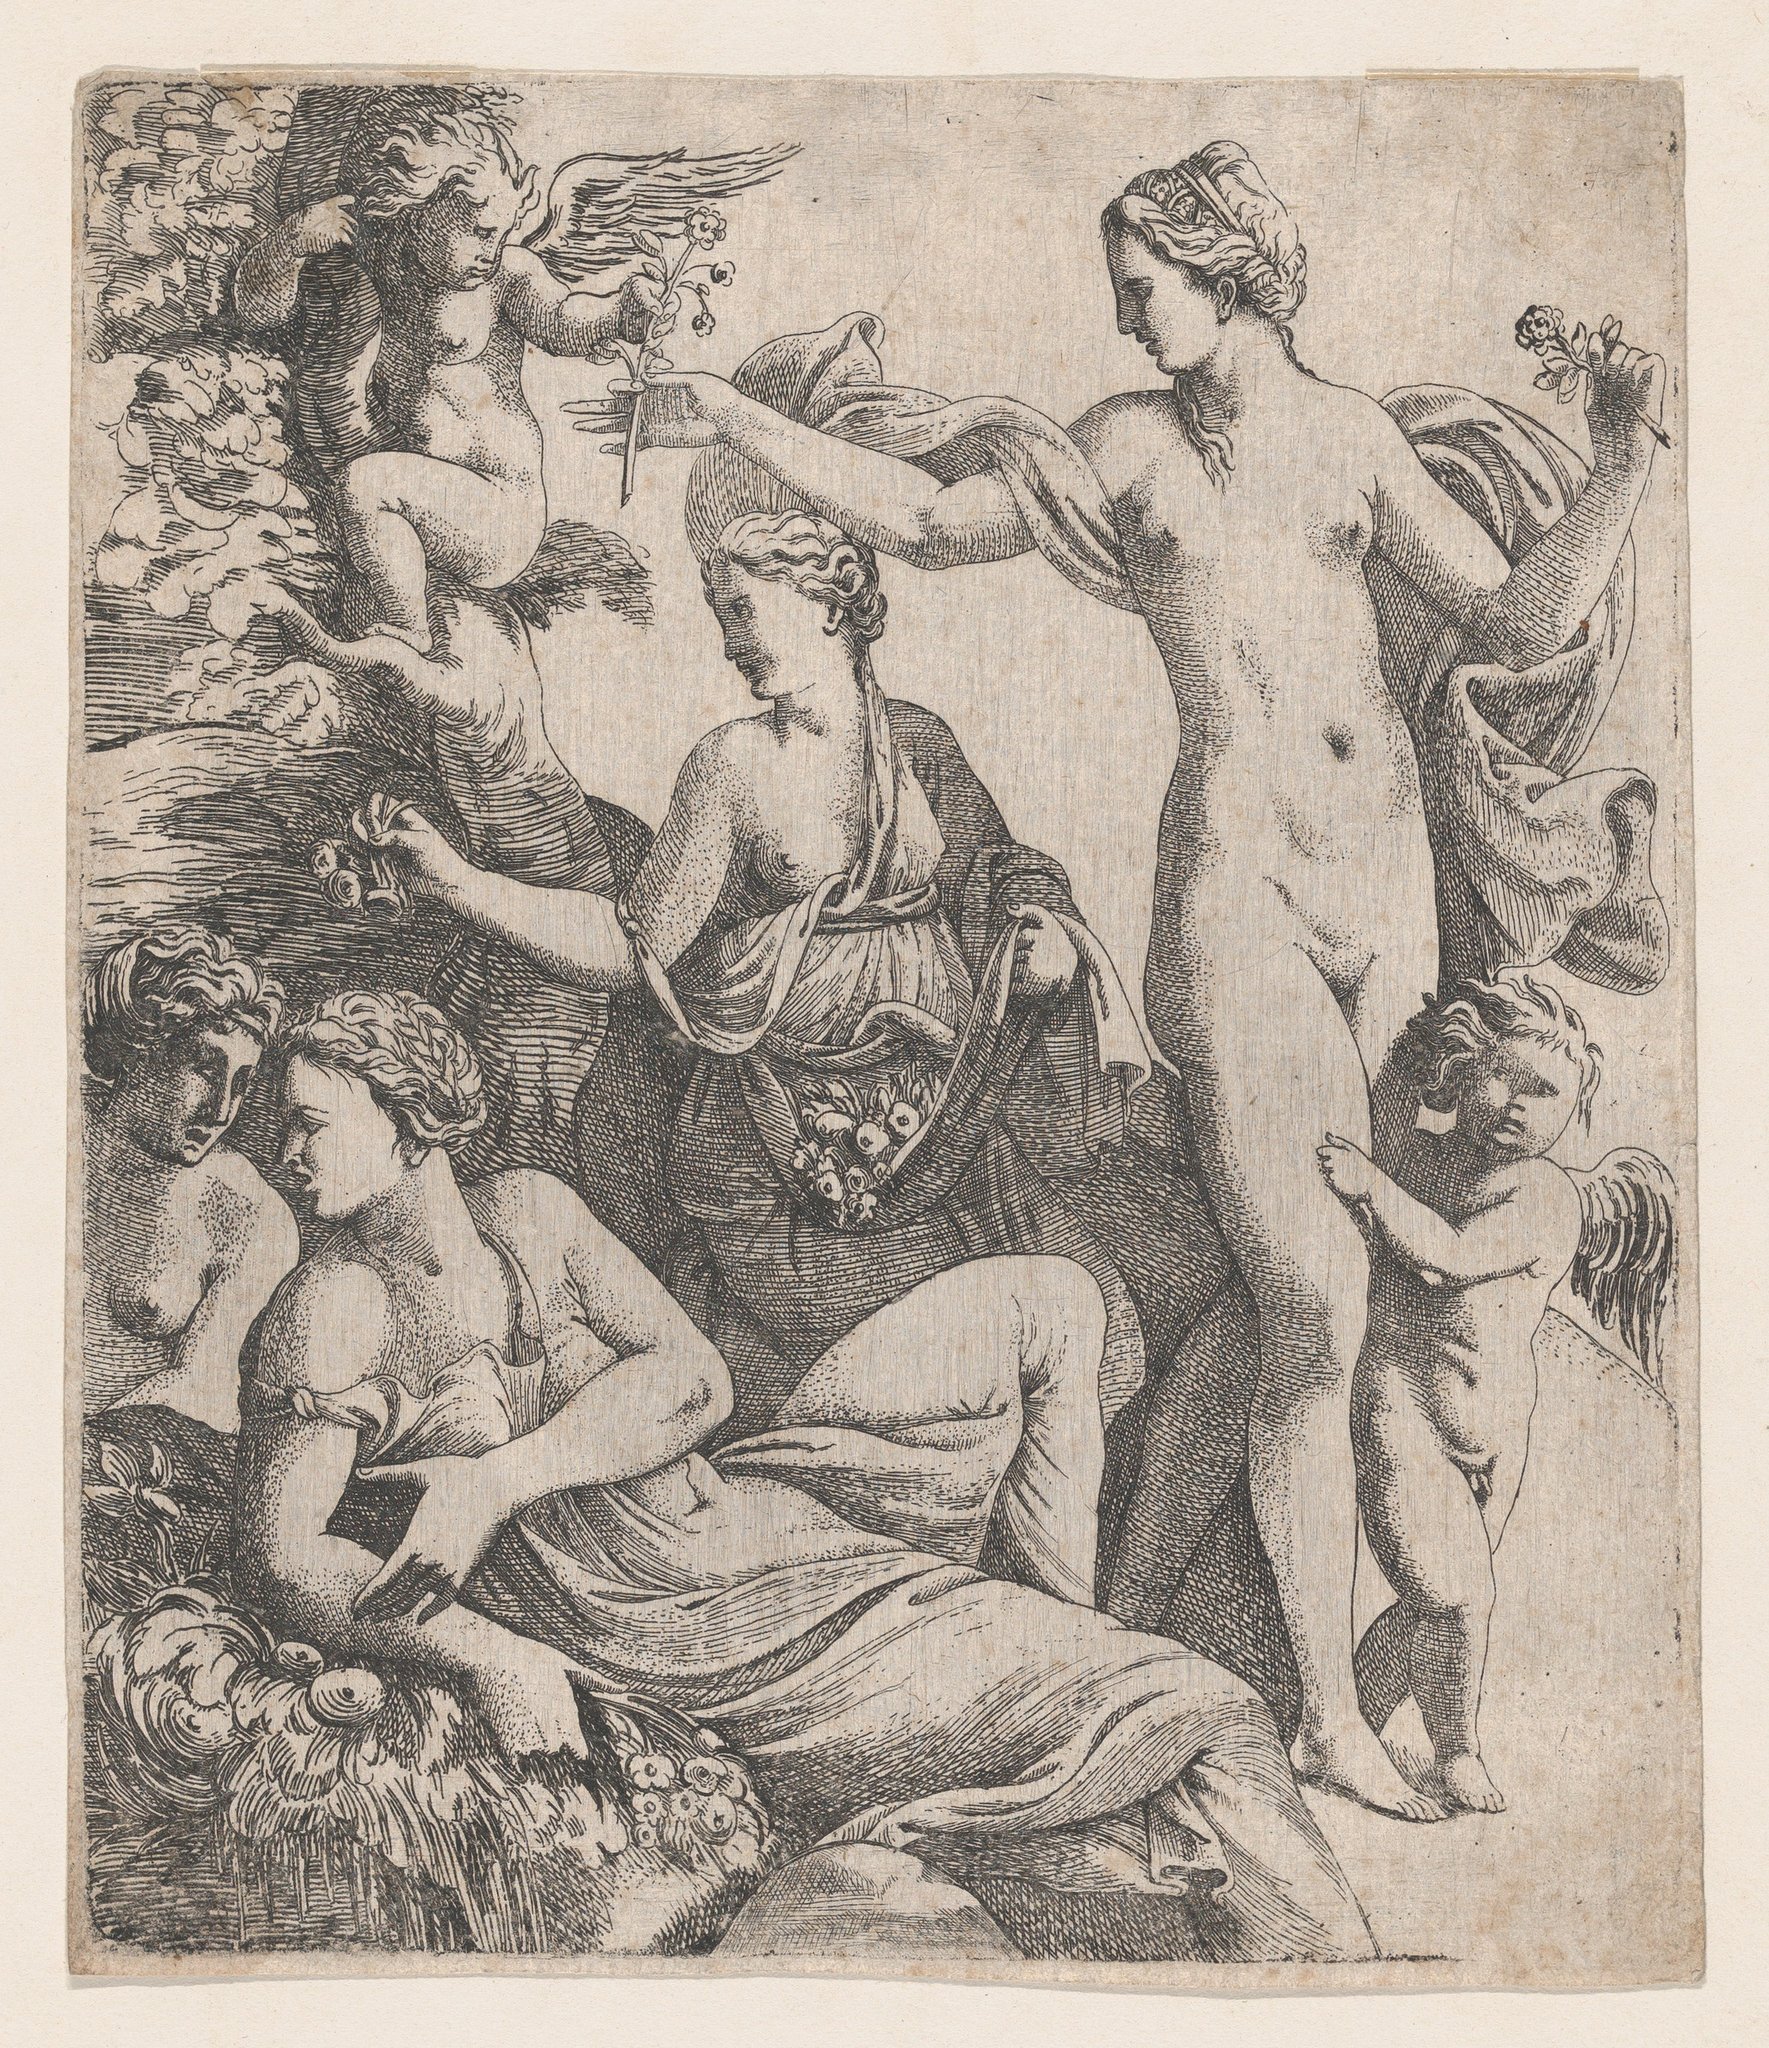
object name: print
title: Venus, standing with the three Graces, is offered a flower from a putto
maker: pierre biard ii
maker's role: artist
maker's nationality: french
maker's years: 1592-1661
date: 1607-1661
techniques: engraving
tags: venus